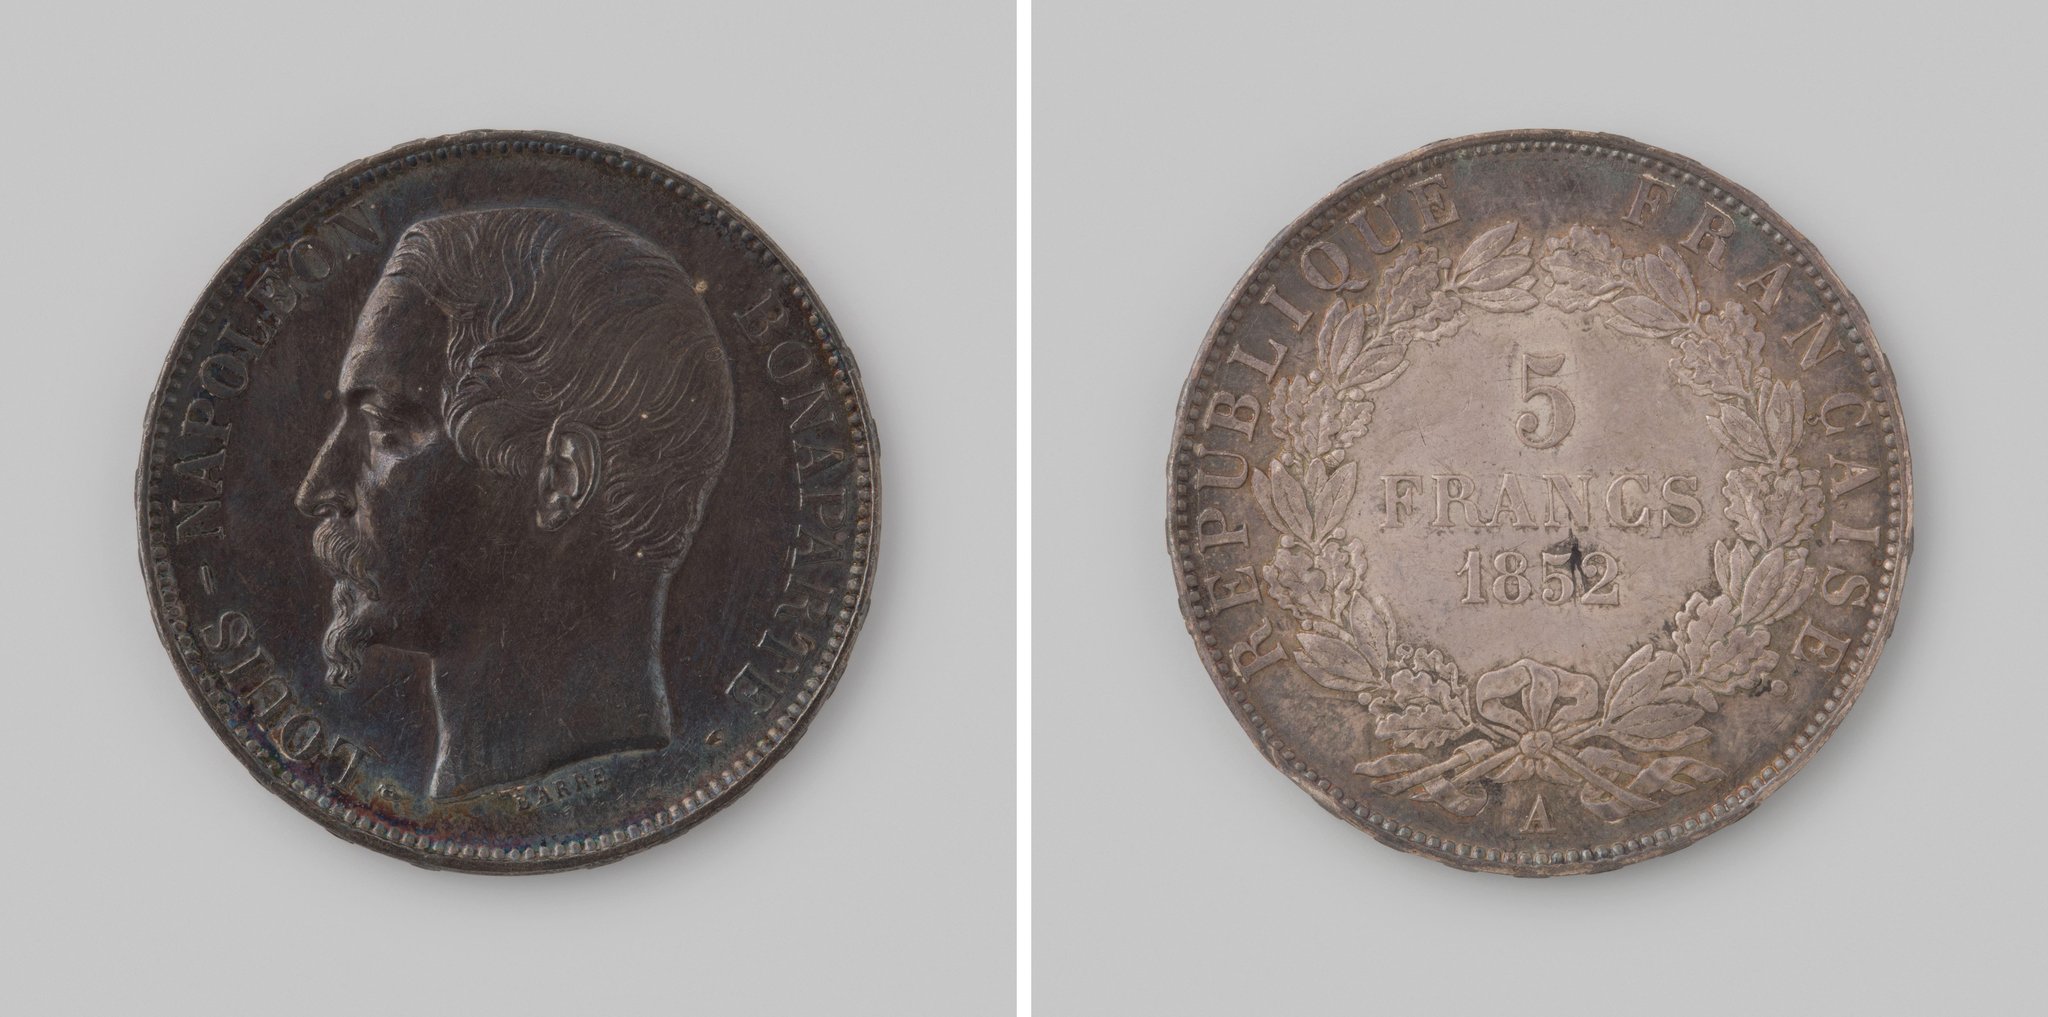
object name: coin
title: Frankrijk, Tweede Republiek met Louis Napoleon als president, 5 francs,1852 A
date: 1852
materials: silver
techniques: striking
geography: paris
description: Zilveren munt. Voorzijde: hoofd van de president naar links. Omschrift: Louis-Napoleon Bonaparte. Keerzijde: binnen twee samengebonden takken waarde-aanduiding in twee regels, waaronder jaartal. Onderaan de letter A [=Parijs]. Opliggend randschrift.